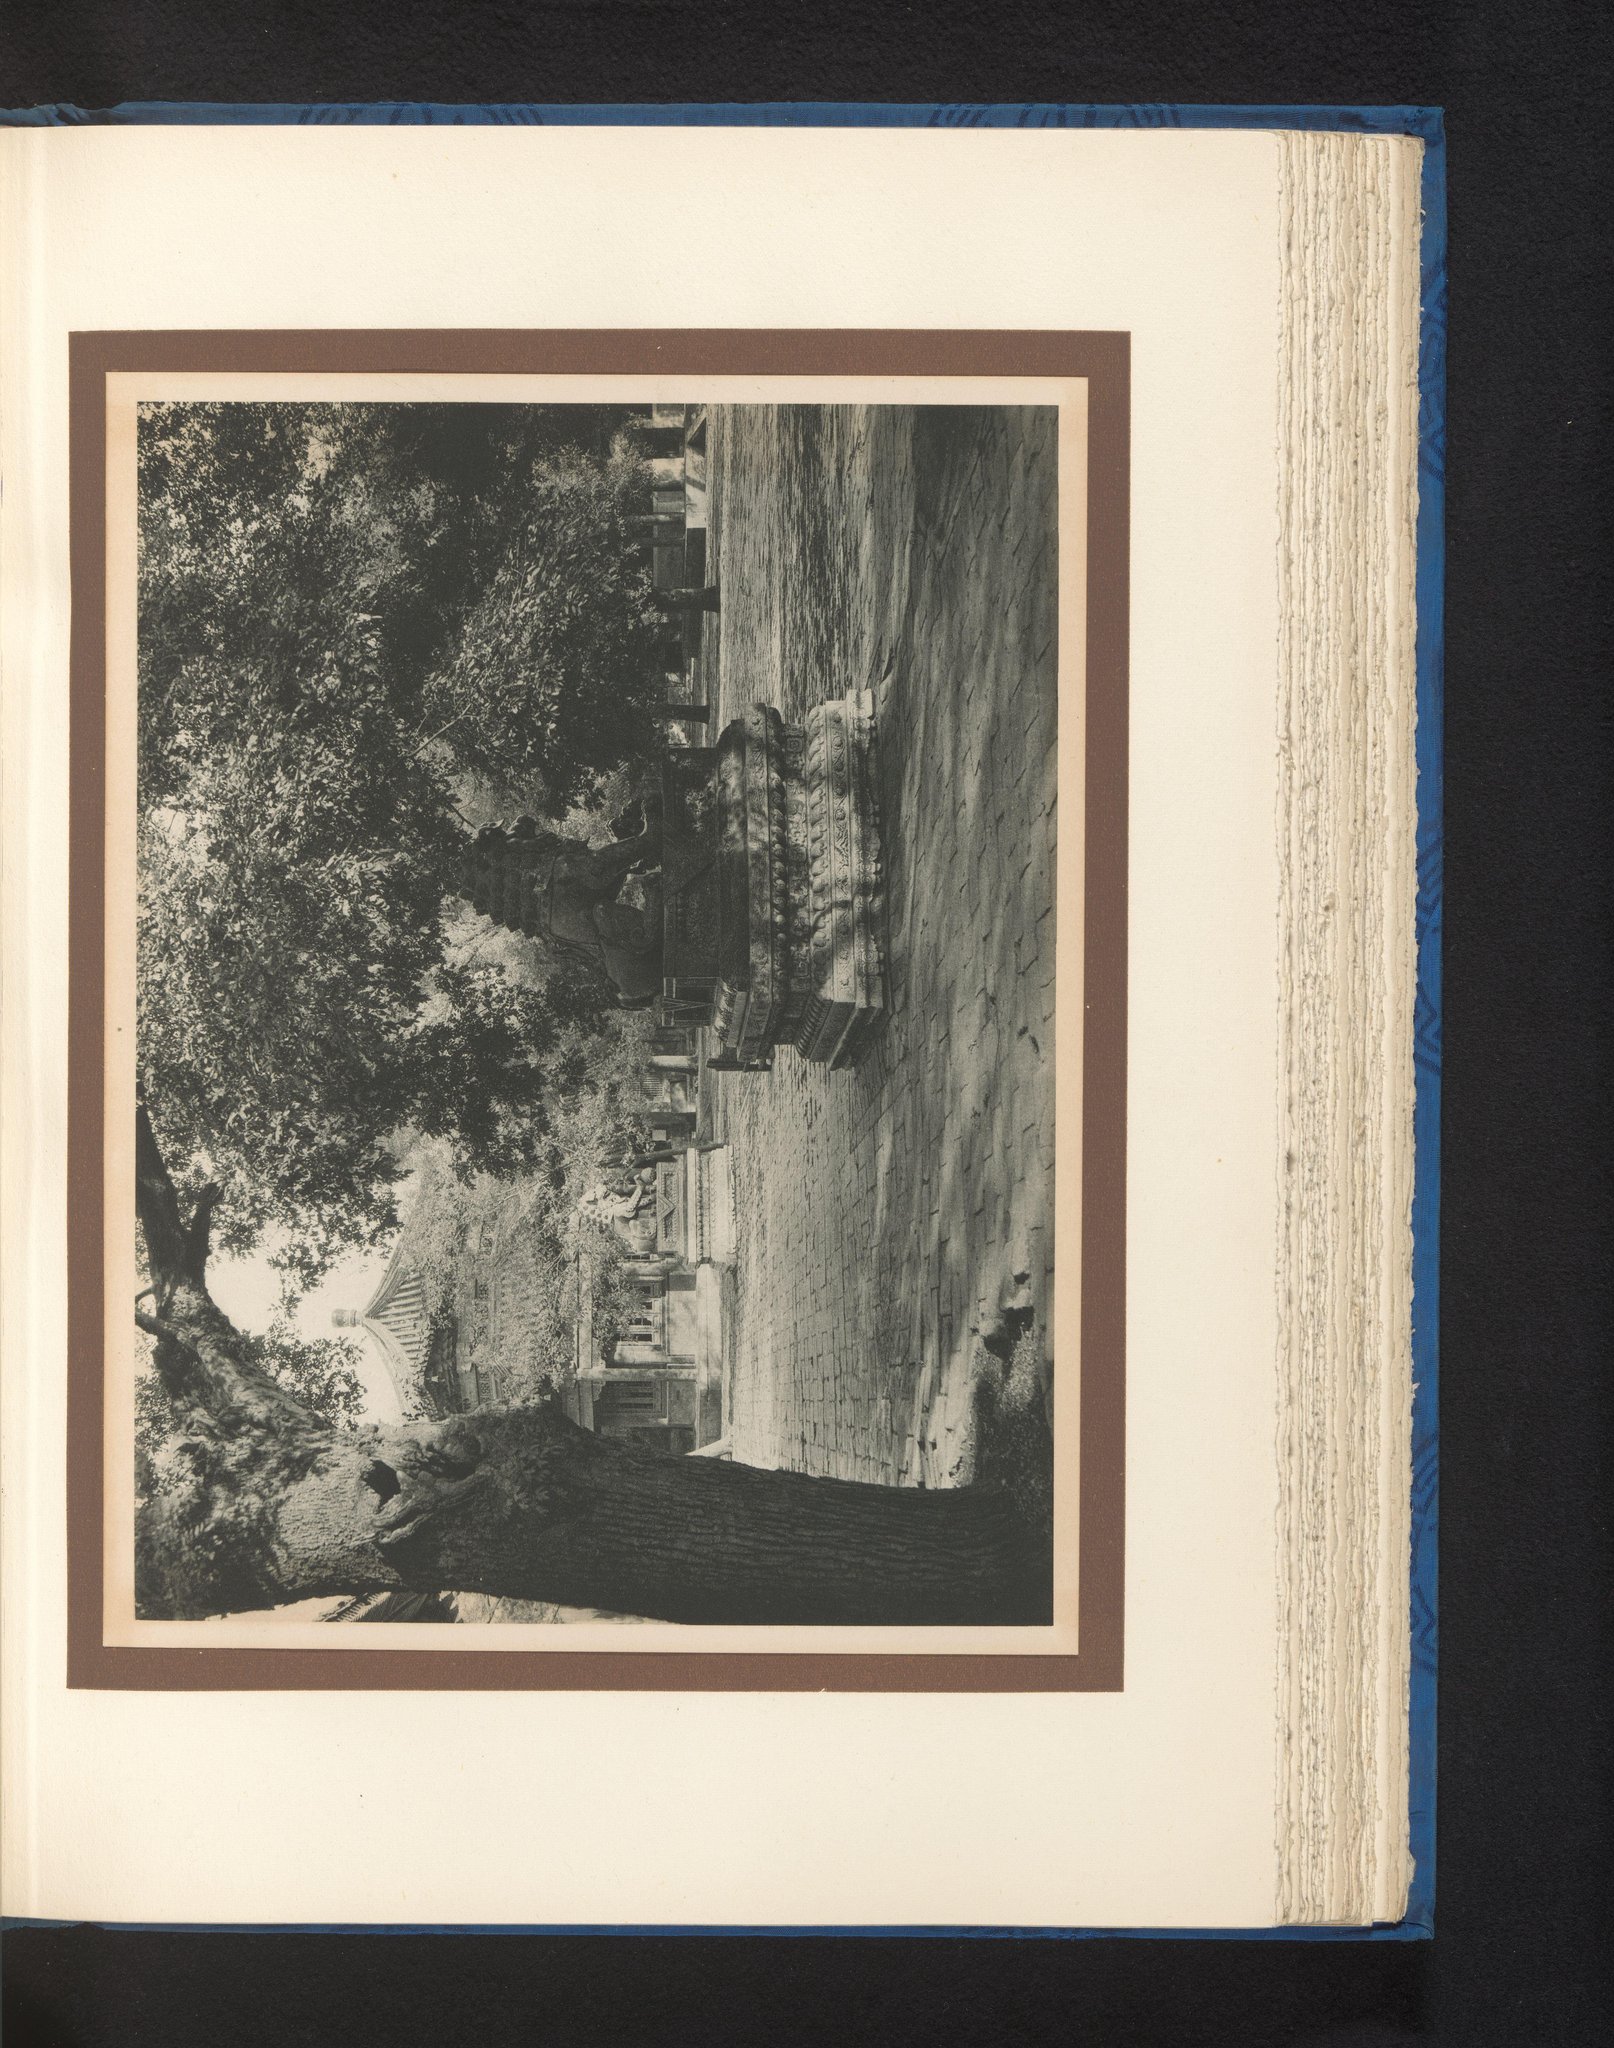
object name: photomechanical print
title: Binnenplaats bij de Yonghetempel te Peking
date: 1915-1920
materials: paper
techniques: rotogravure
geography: beijing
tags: courtyard, temple, shrine ~ non-christian religions